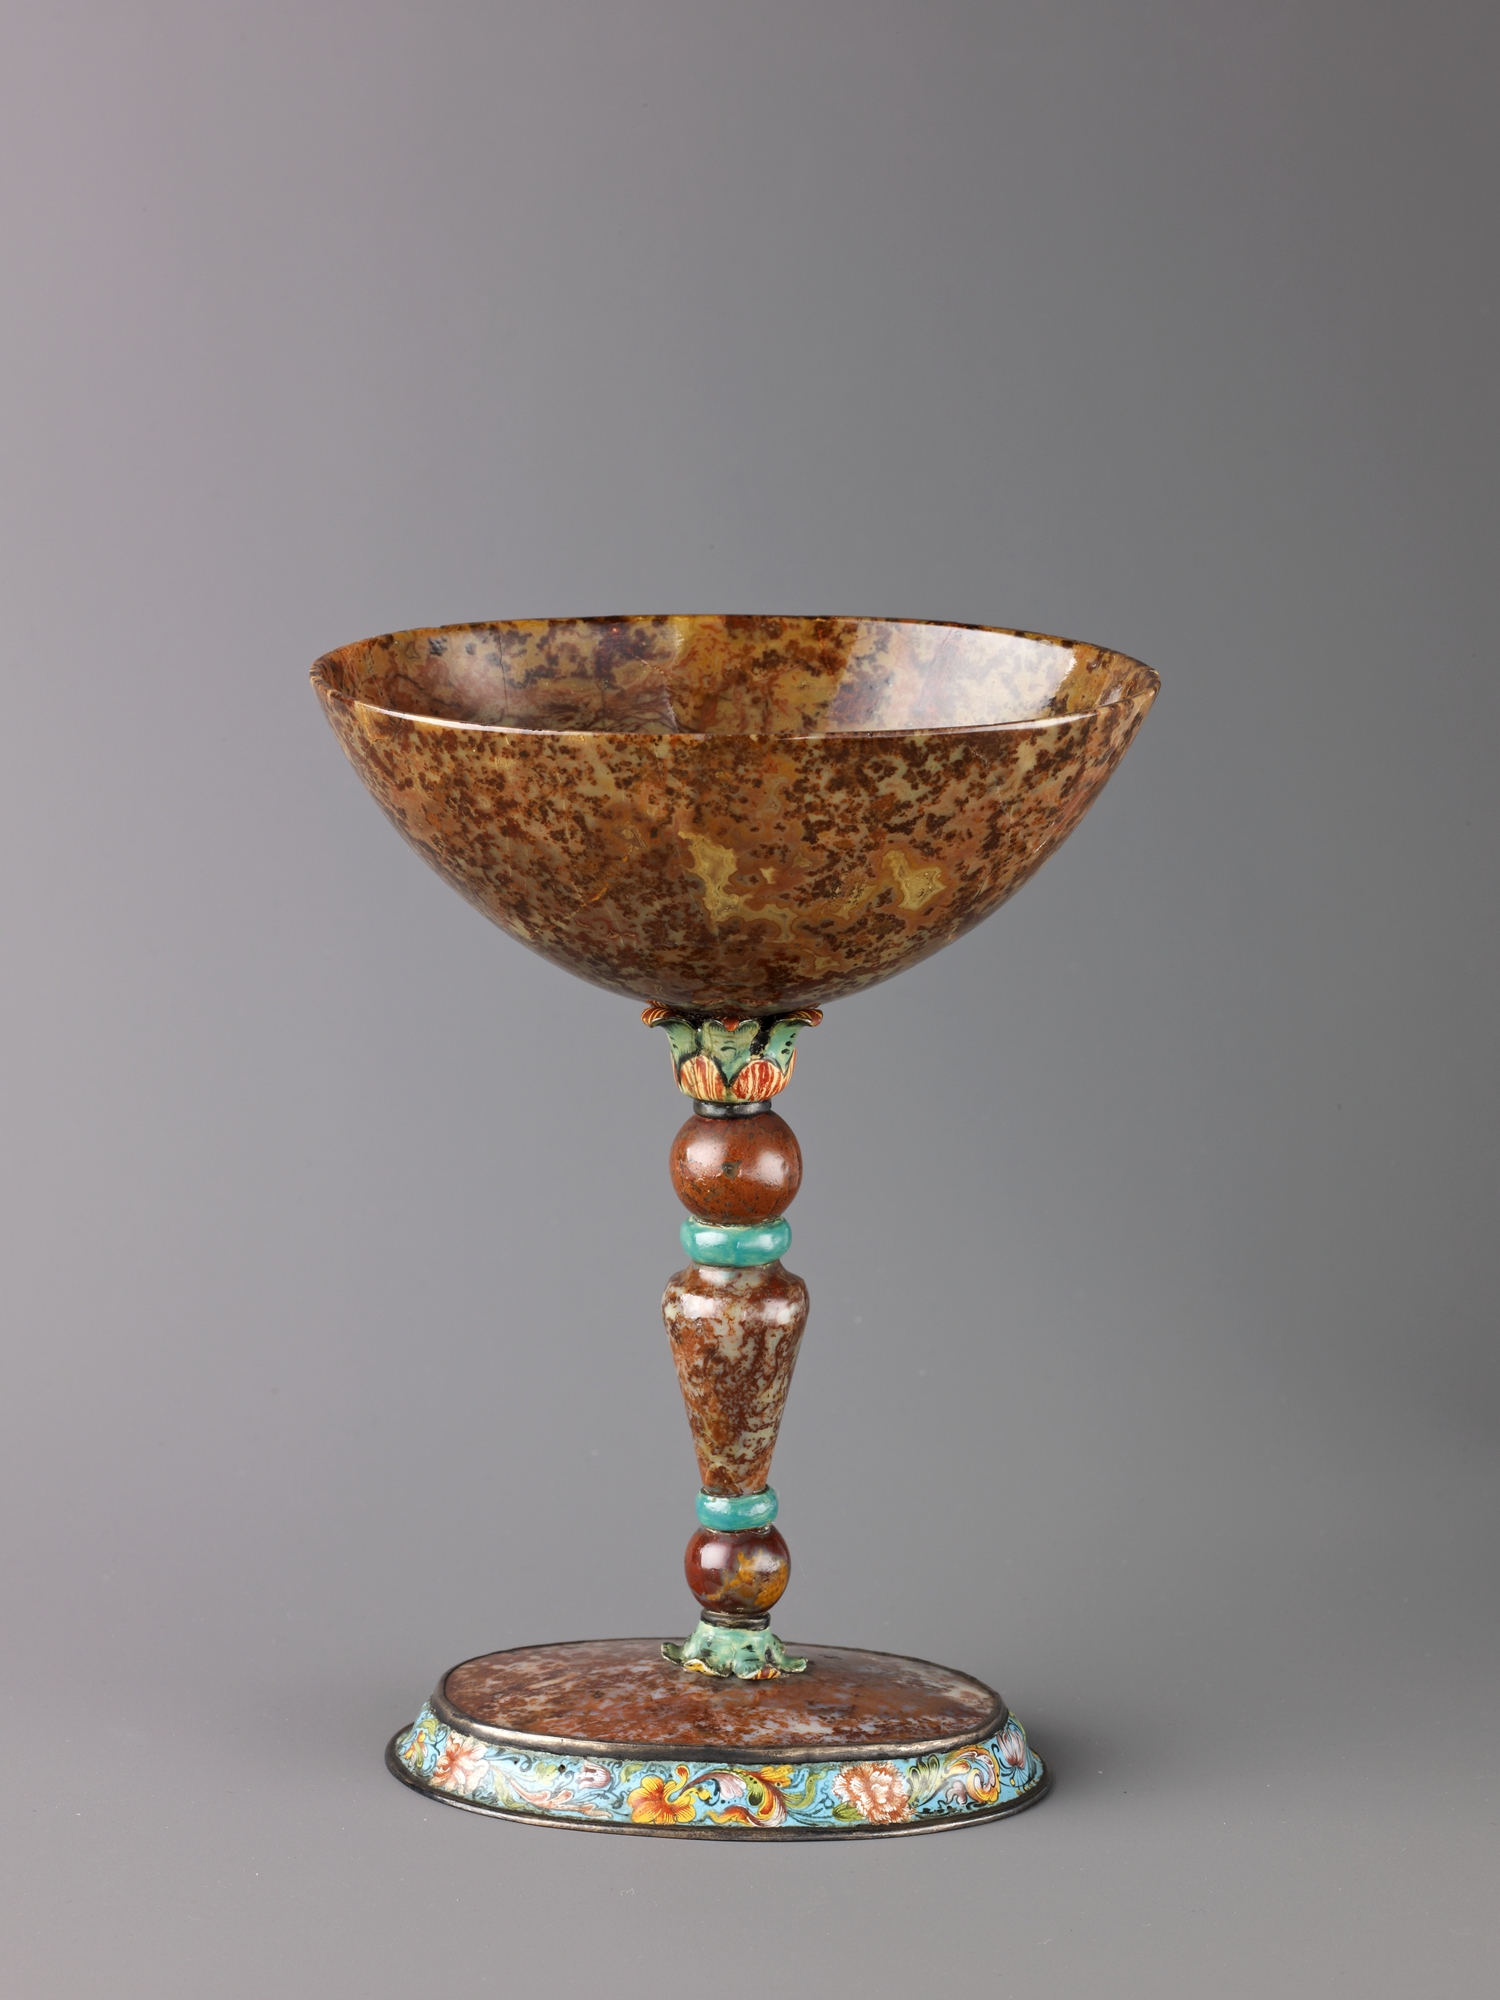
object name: cup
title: Moss agate and enamel stem cup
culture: german, south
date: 1660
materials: stone, enamel, silver gilt